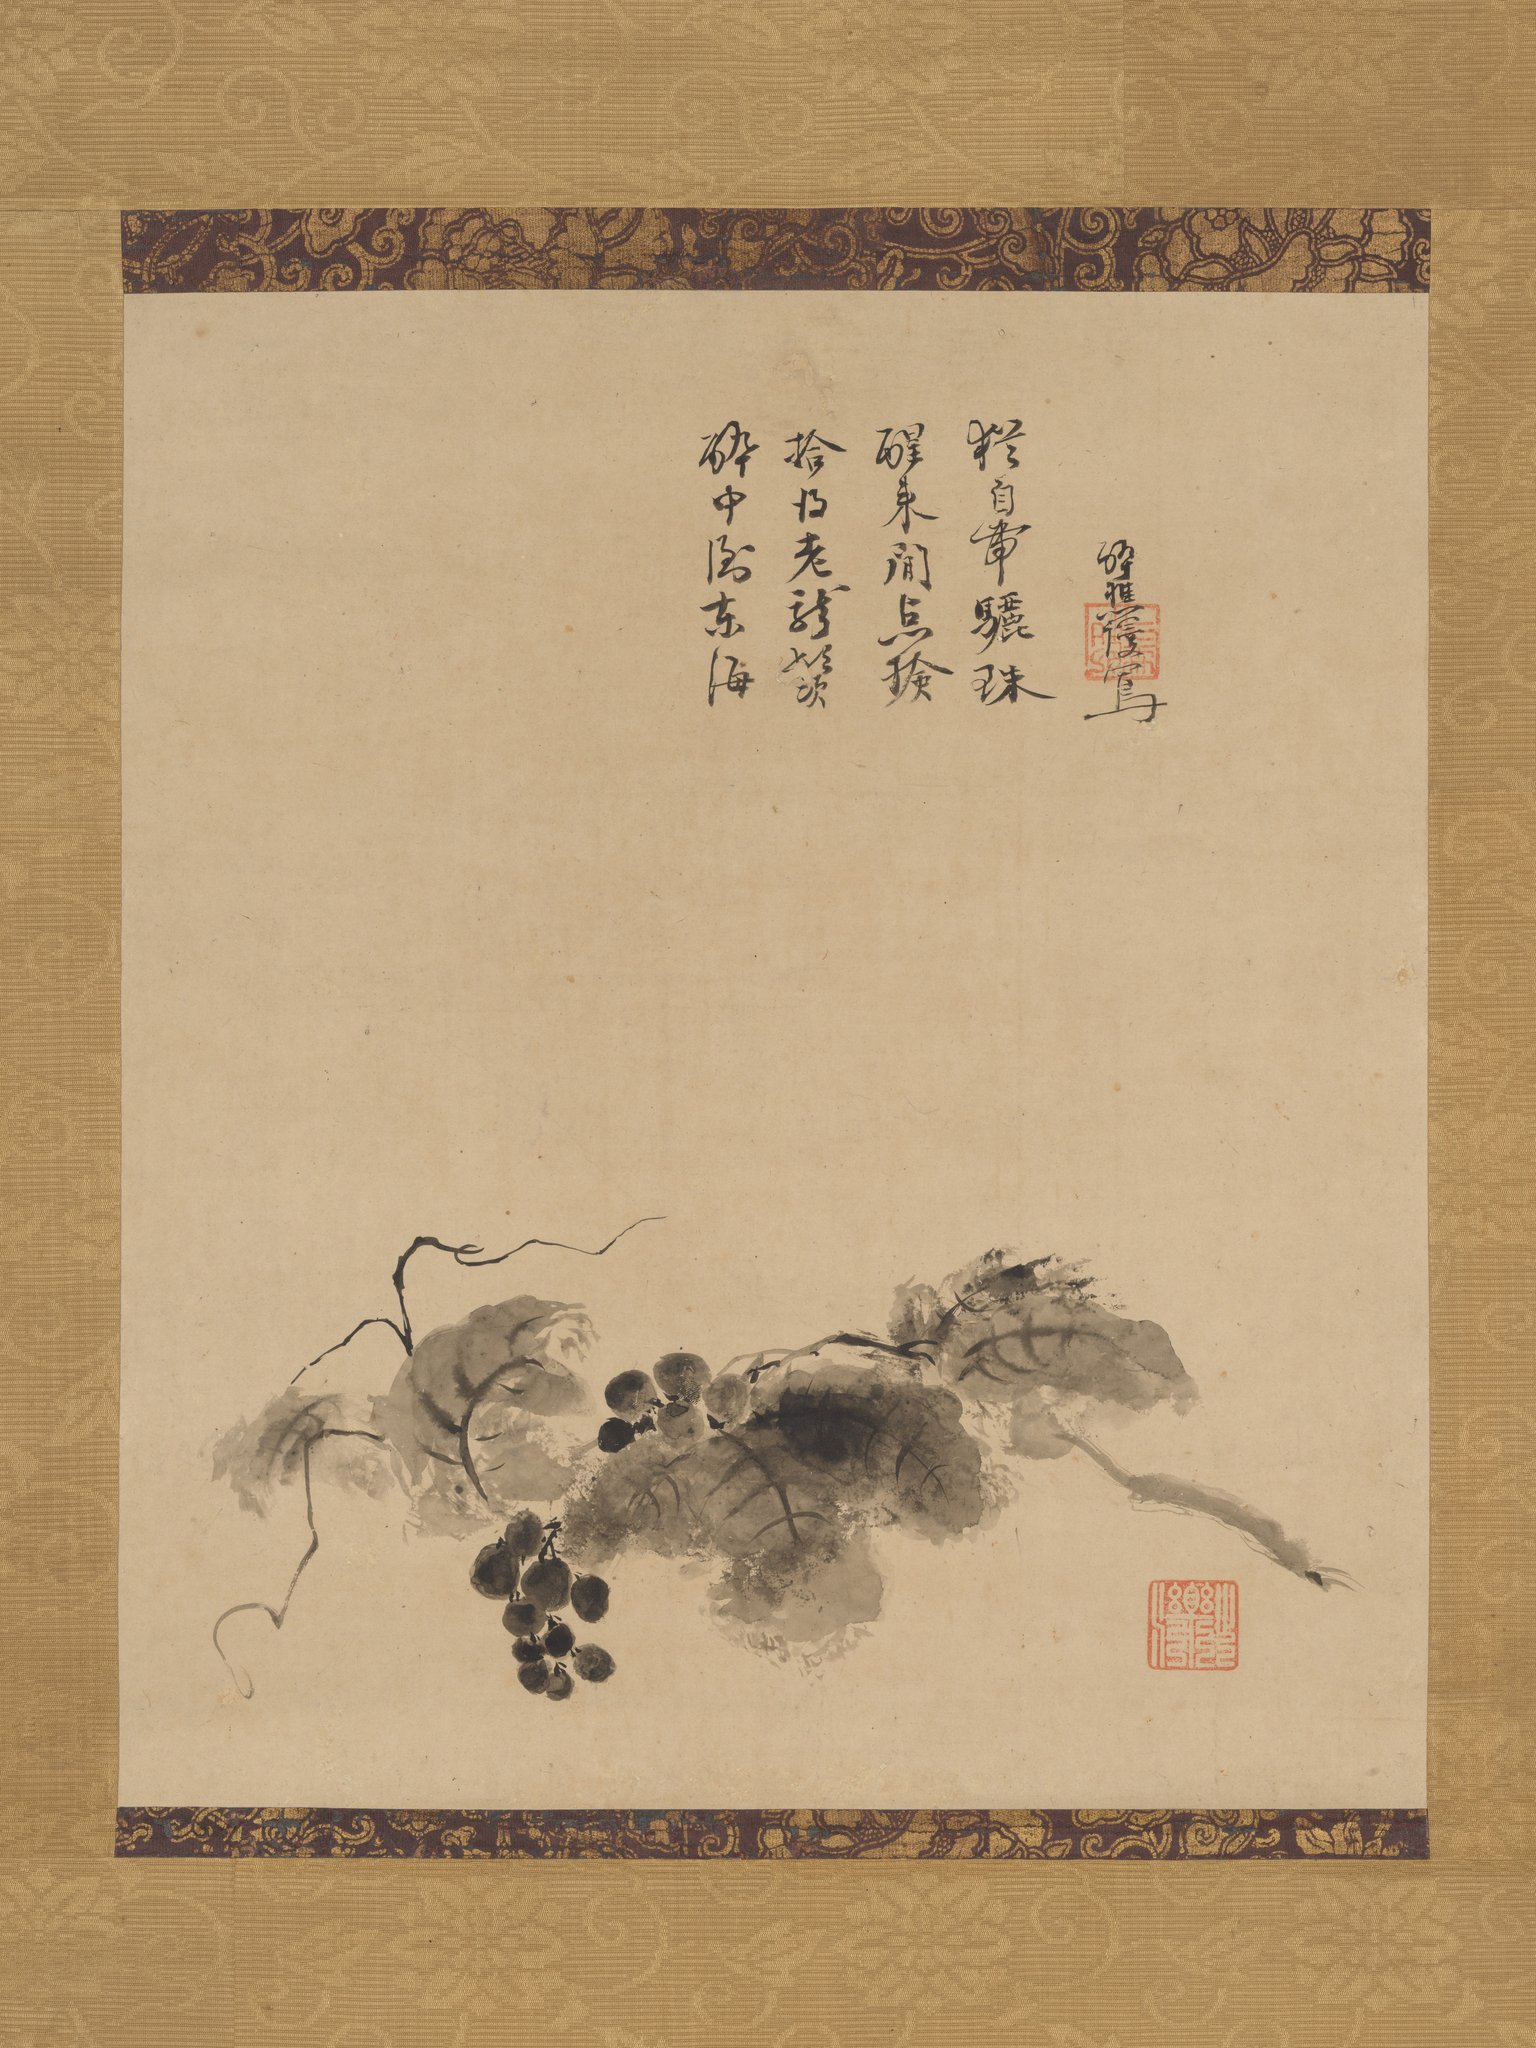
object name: hanging scroll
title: Grapes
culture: japanese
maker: motsurin jōtō (bokusai)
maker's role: artist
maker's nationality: japanese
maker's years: -1492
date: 1480-1492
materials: ink, paper